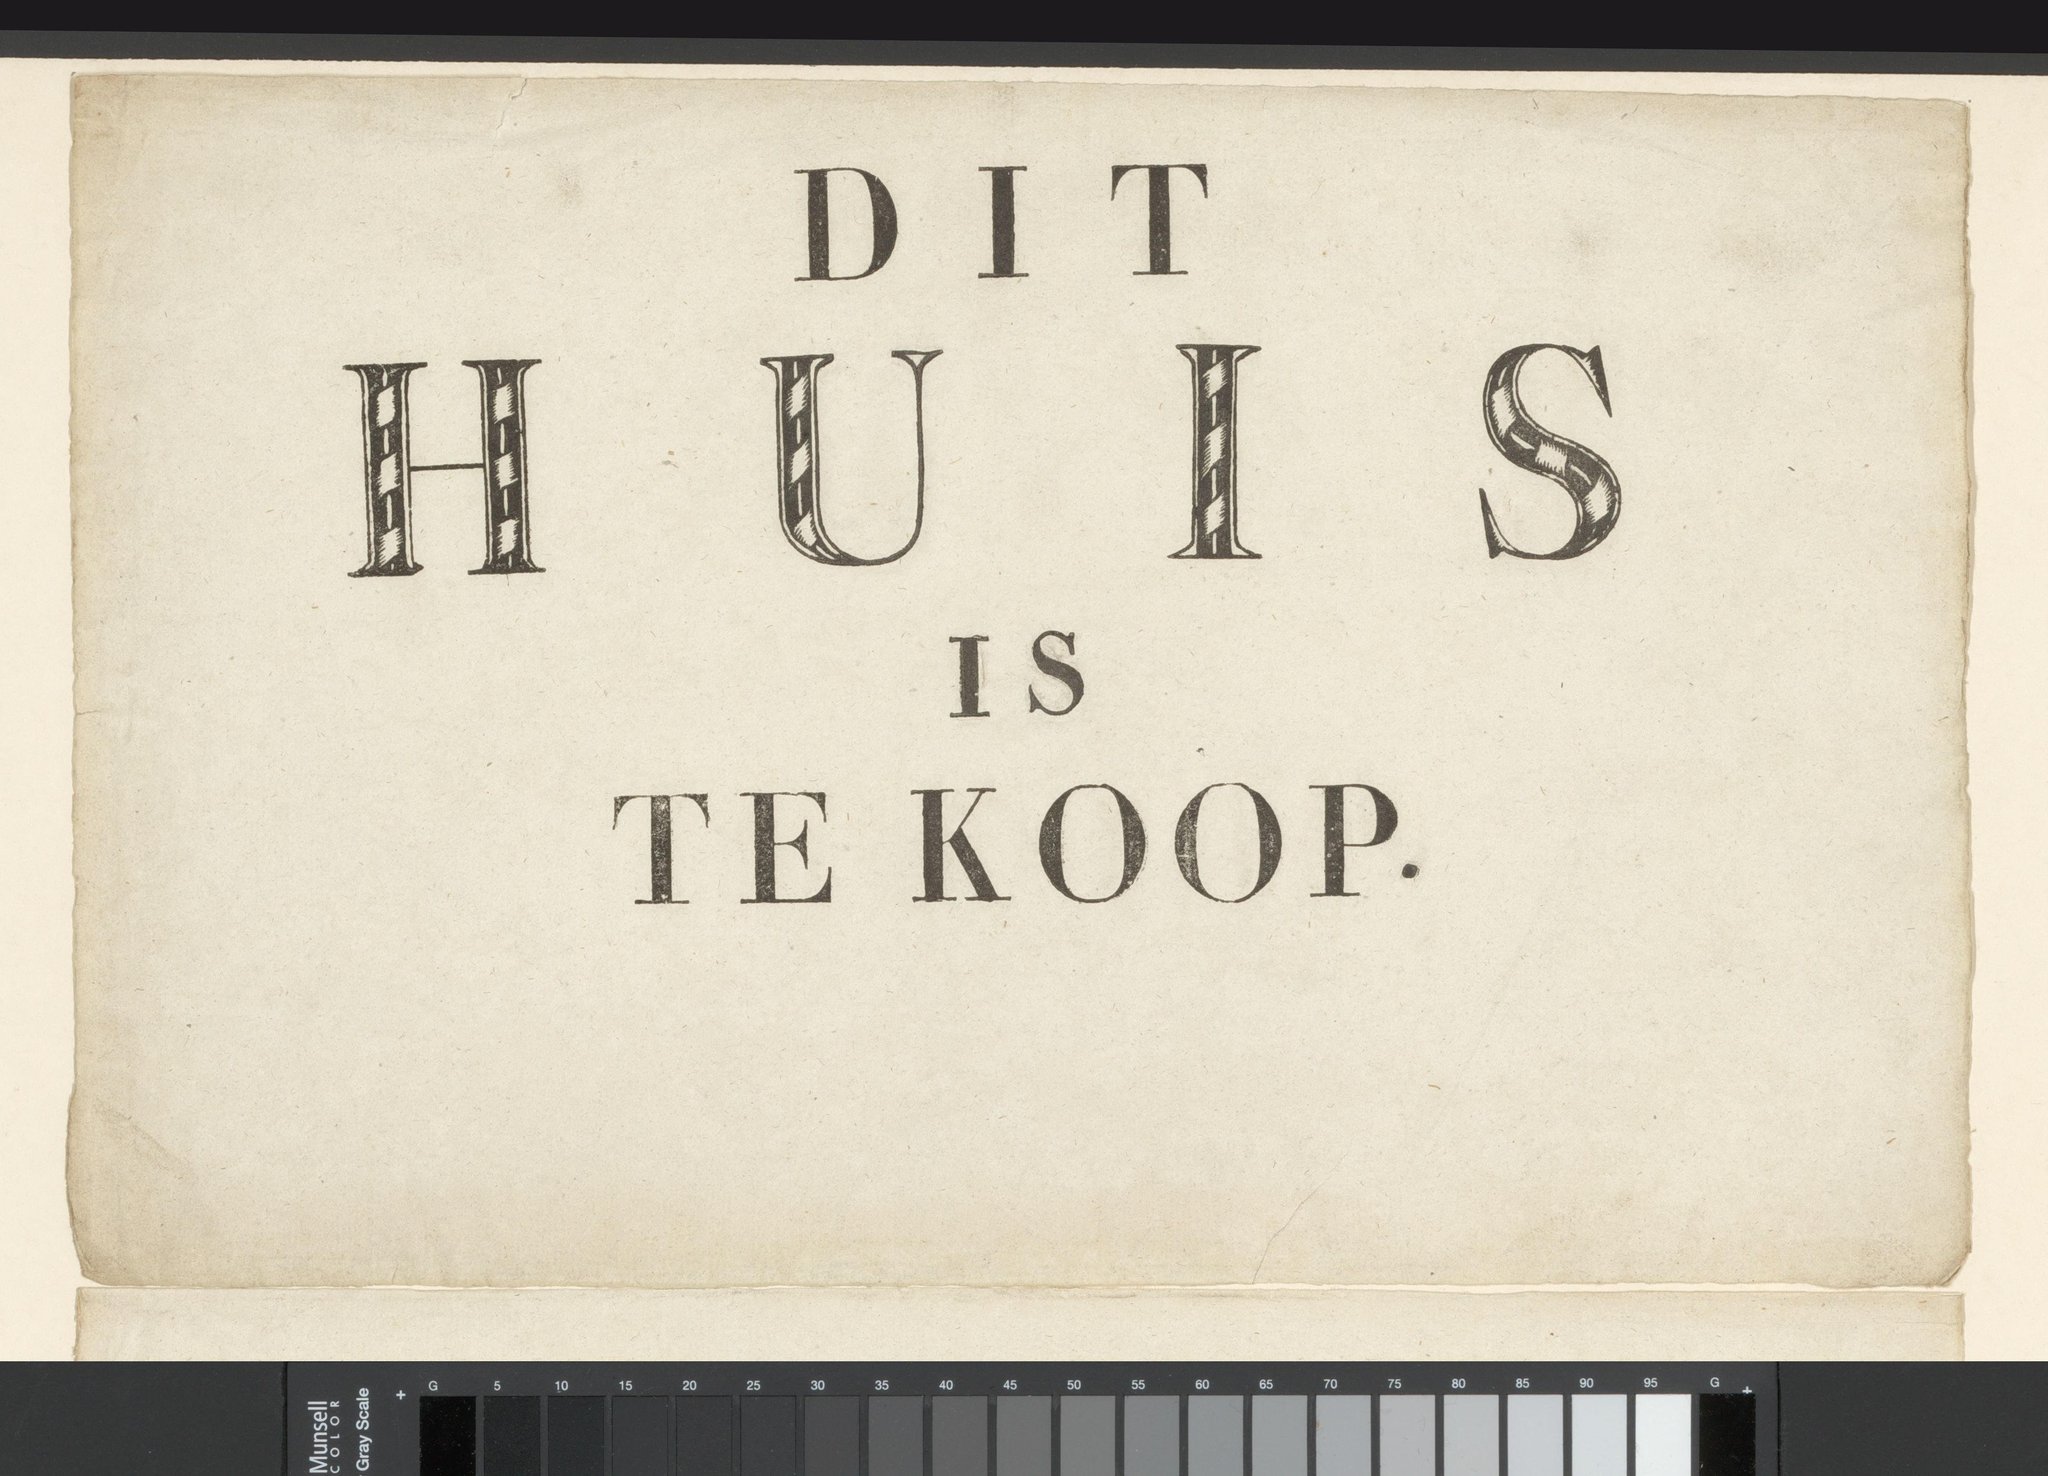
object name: text sheet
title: Dit huis is te koop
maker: Anonymous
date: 1700-1799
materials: paper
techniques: letterpress printing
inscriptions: collector's mark: Lugt 1641, stamp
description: Onderwerpsrubrieken binnen de Atlas Zeden en Gewoonten: Handel, nijverheid en verkeer, Koophandel, Veilingen, Makelaardij en Verzekeringswezen. Kamers te huur.